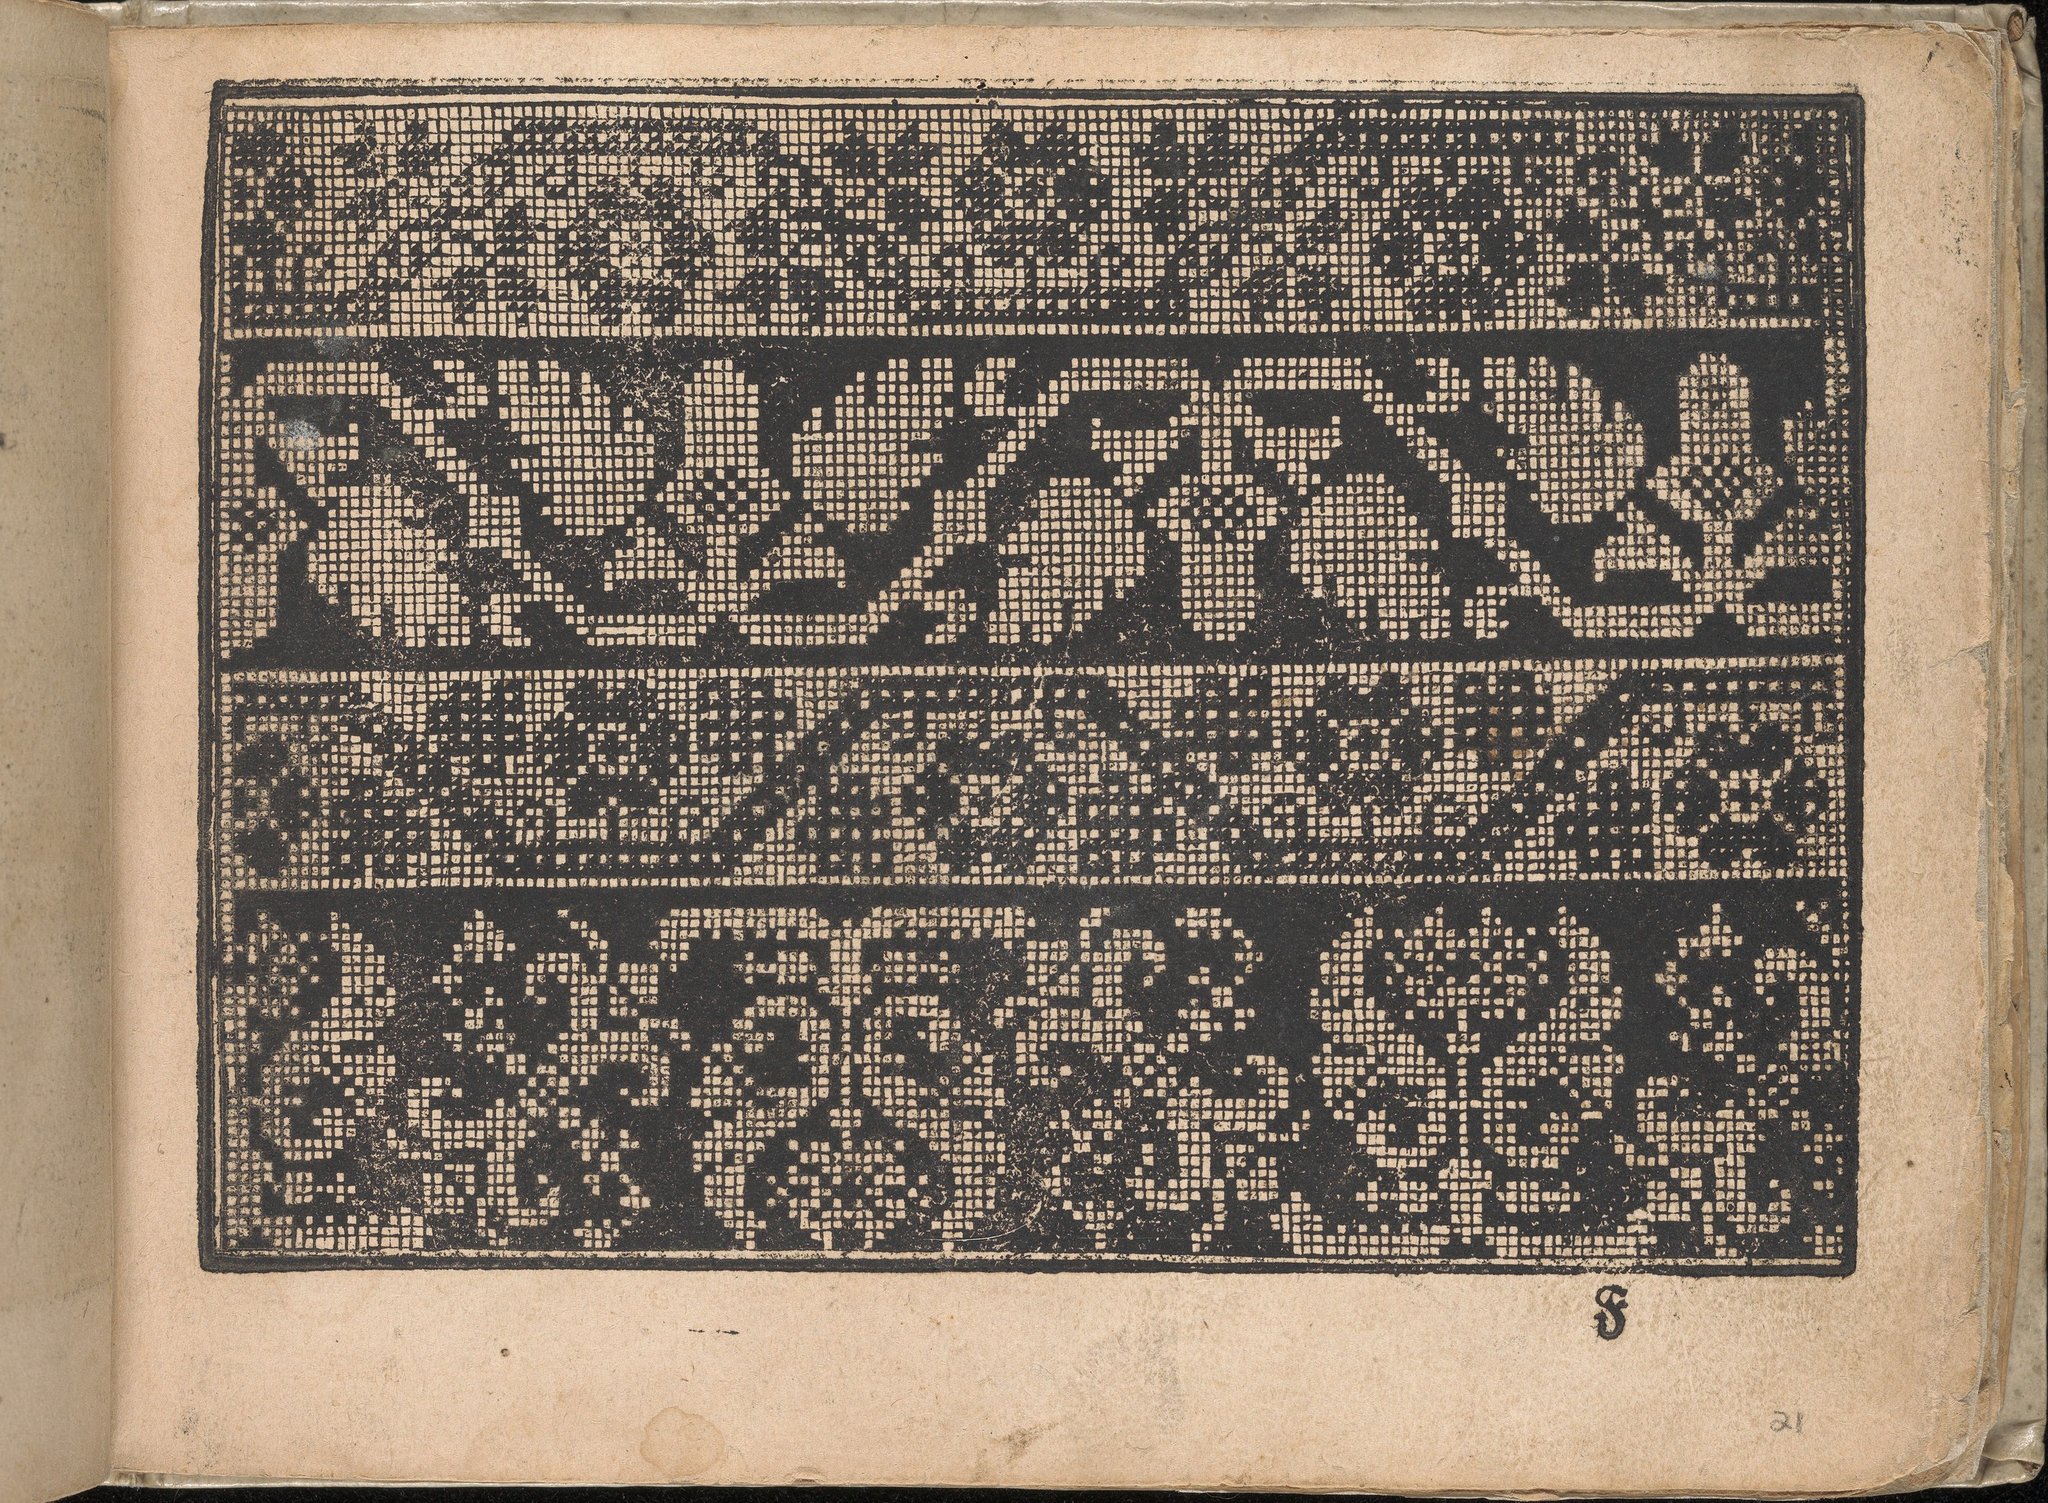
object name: book print ornament architecture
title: Neu künstlich Modelbuch (page 21r)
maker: bernhard jobin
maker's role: publisher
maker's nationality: swiss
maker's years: 1535-1597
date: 1598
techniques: woodcut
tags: flowers